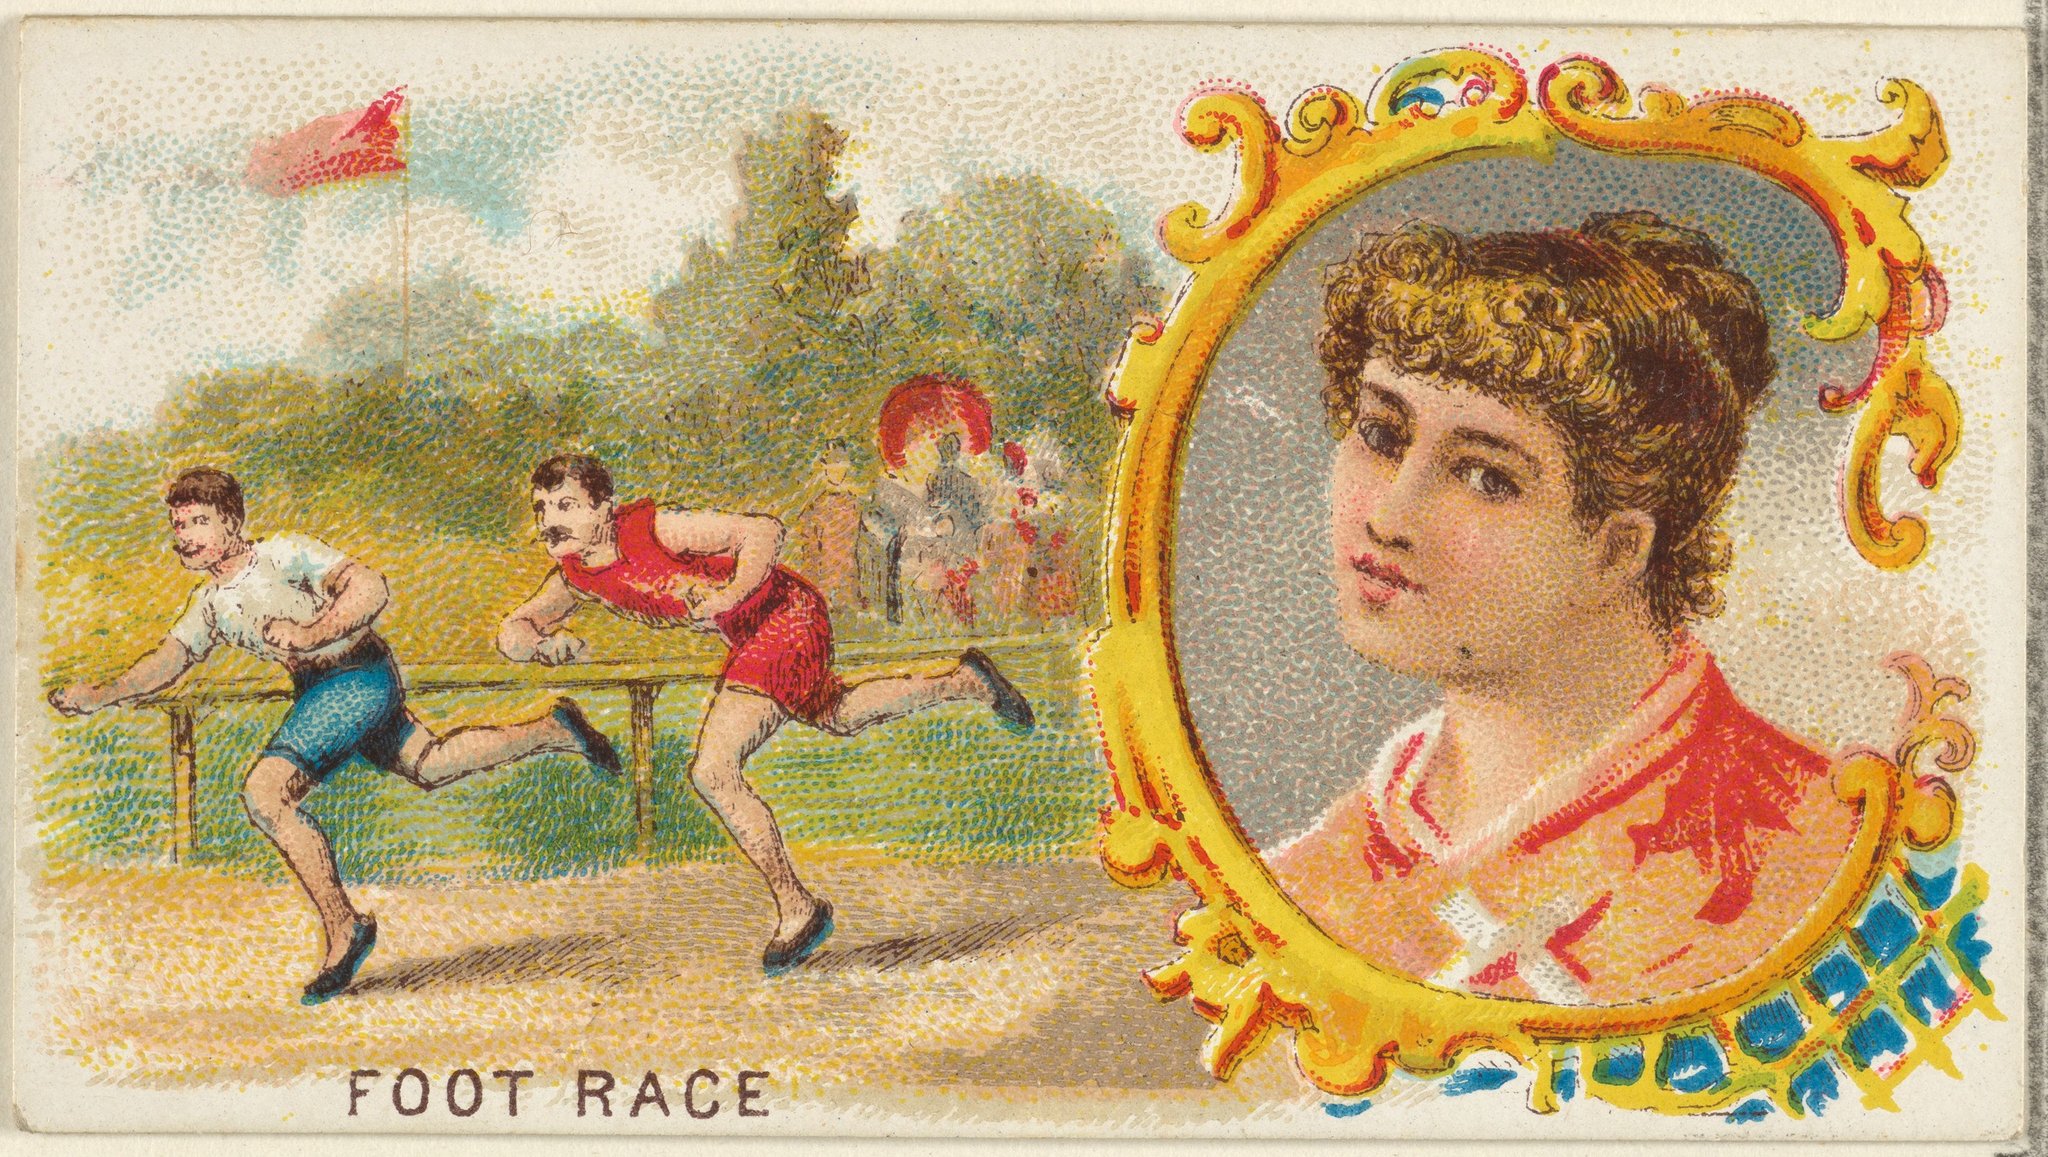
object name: print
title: Foot Race, from the Games and Sports series (N165) for Old Judge Cigarettes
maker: goodwin & company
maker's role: publisher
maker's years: 1850-1950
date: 1889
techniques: color lithograph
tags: men,women,running,athletes